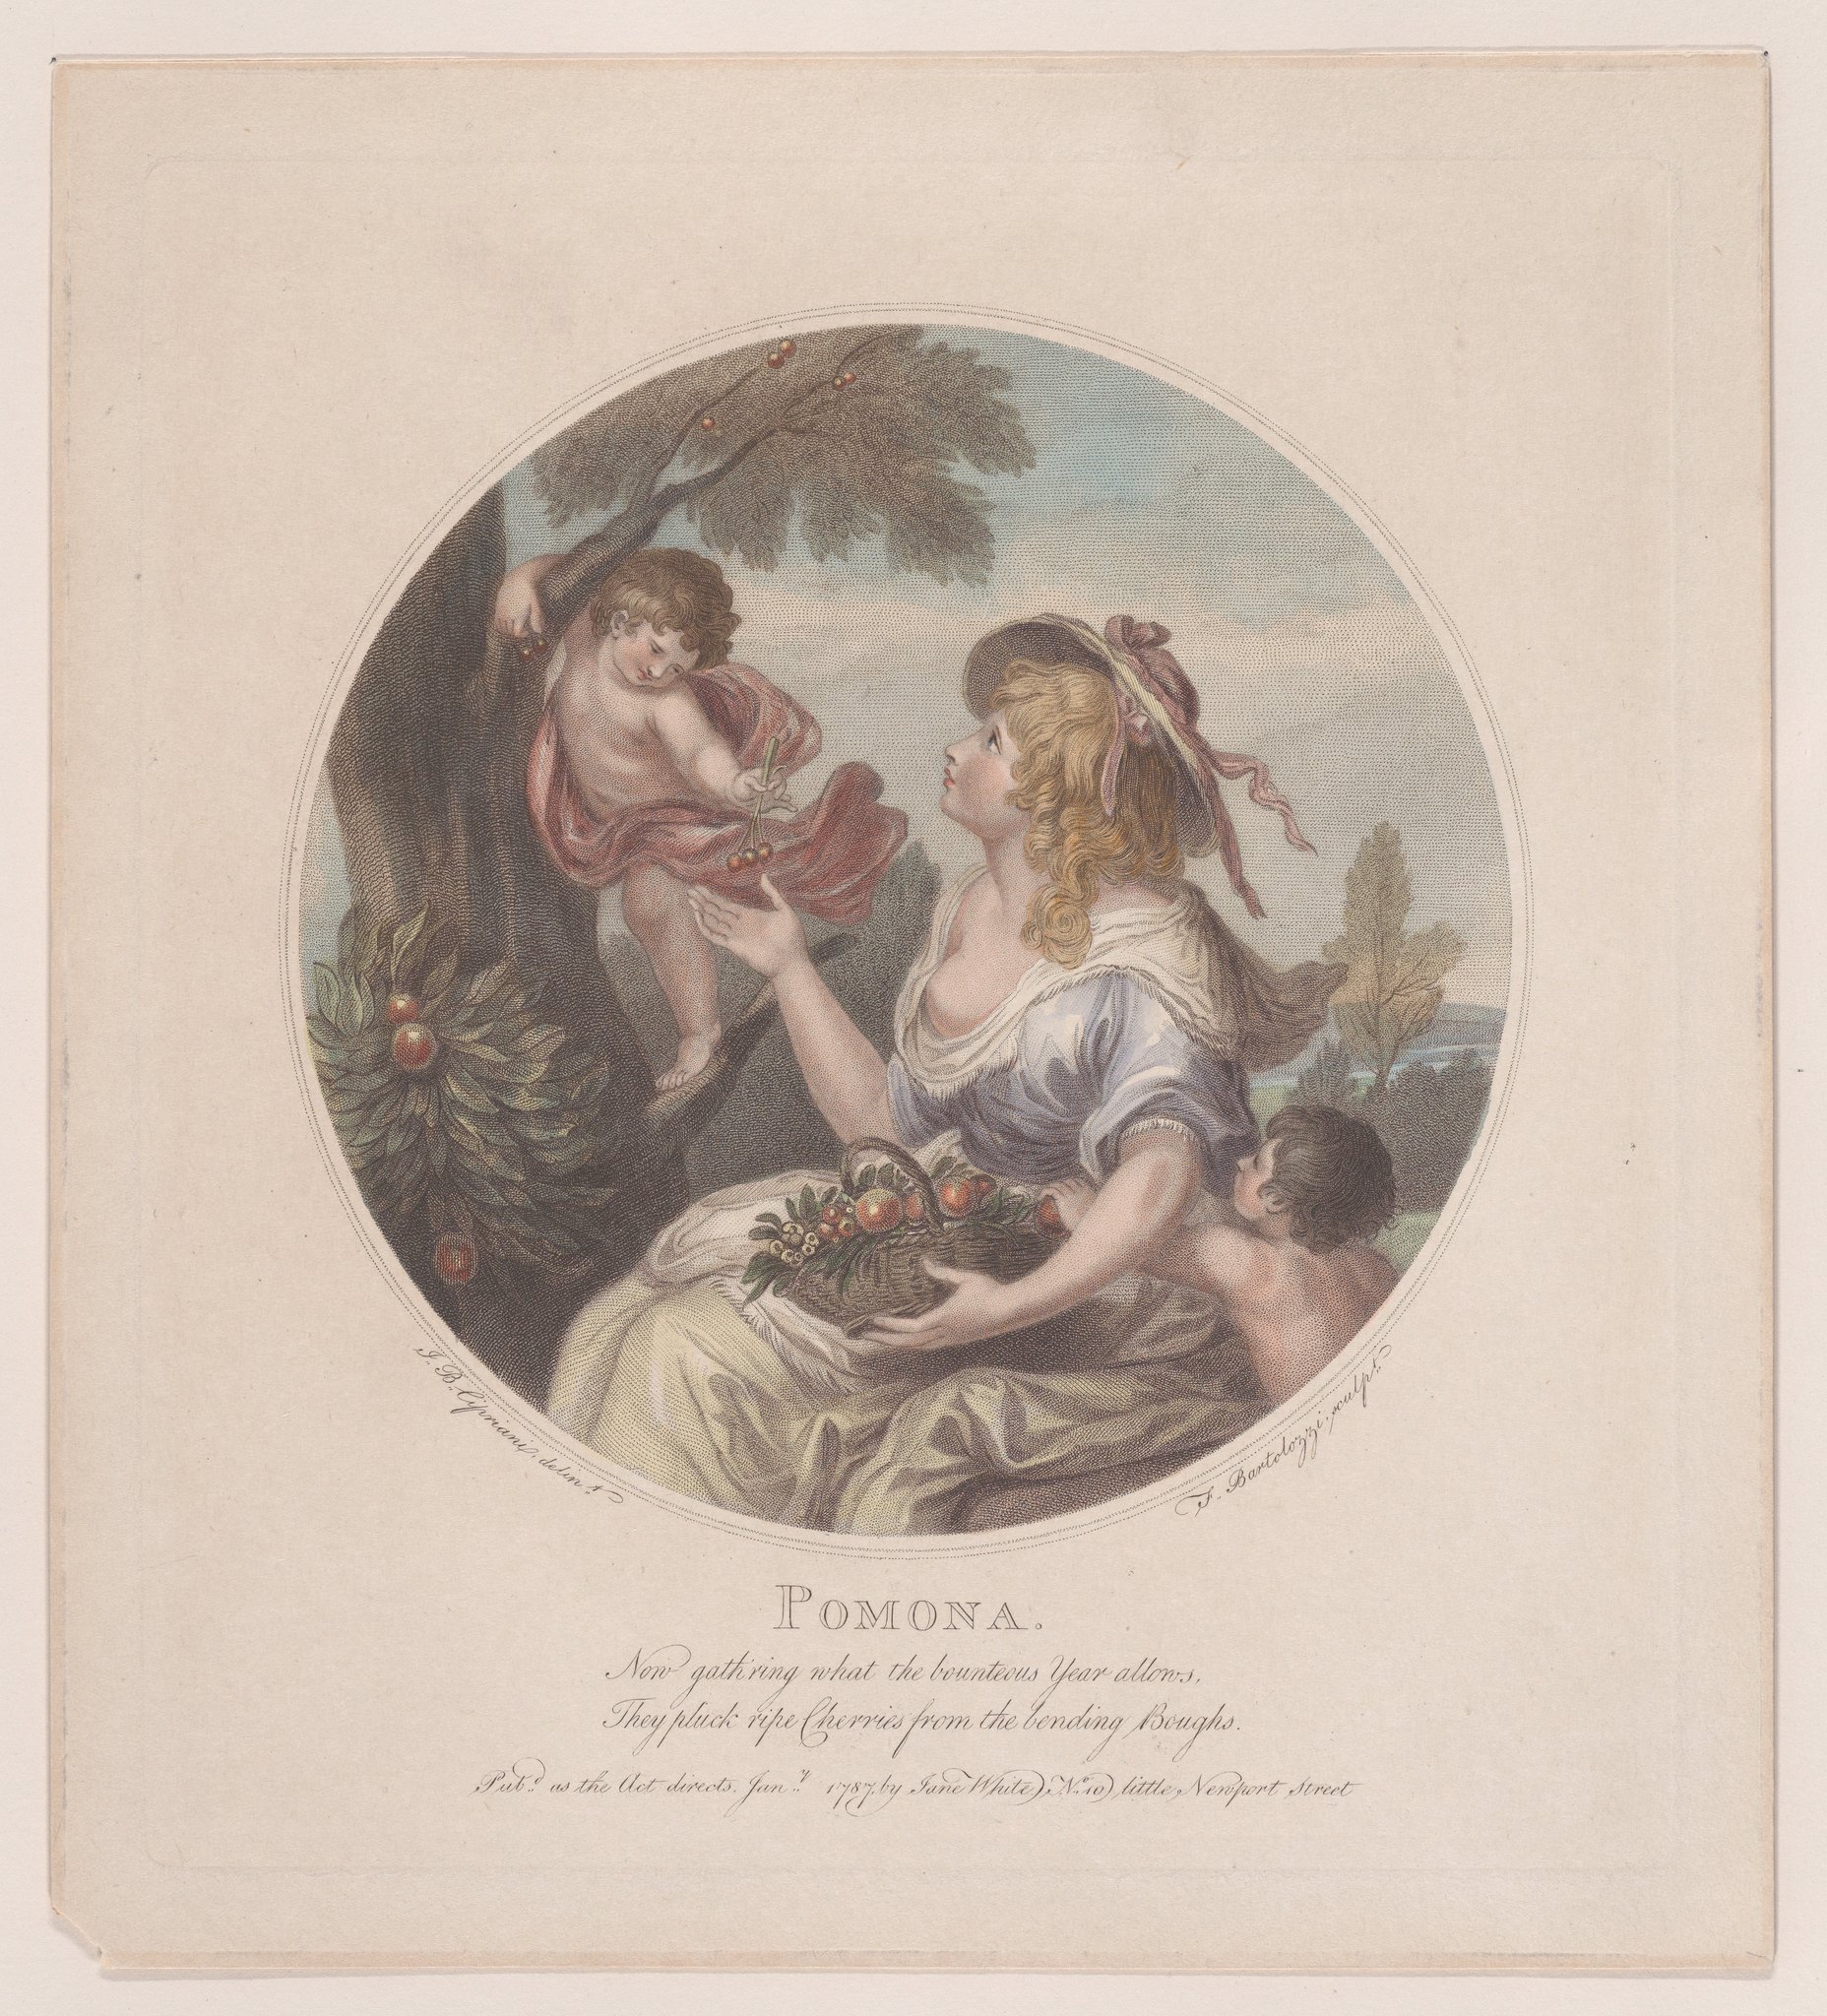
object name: print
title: Pomona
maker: francesco bartolozzi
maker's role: artist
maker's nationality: italian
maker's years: 1728-1815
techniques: etching, hand coloring, engraving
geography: london